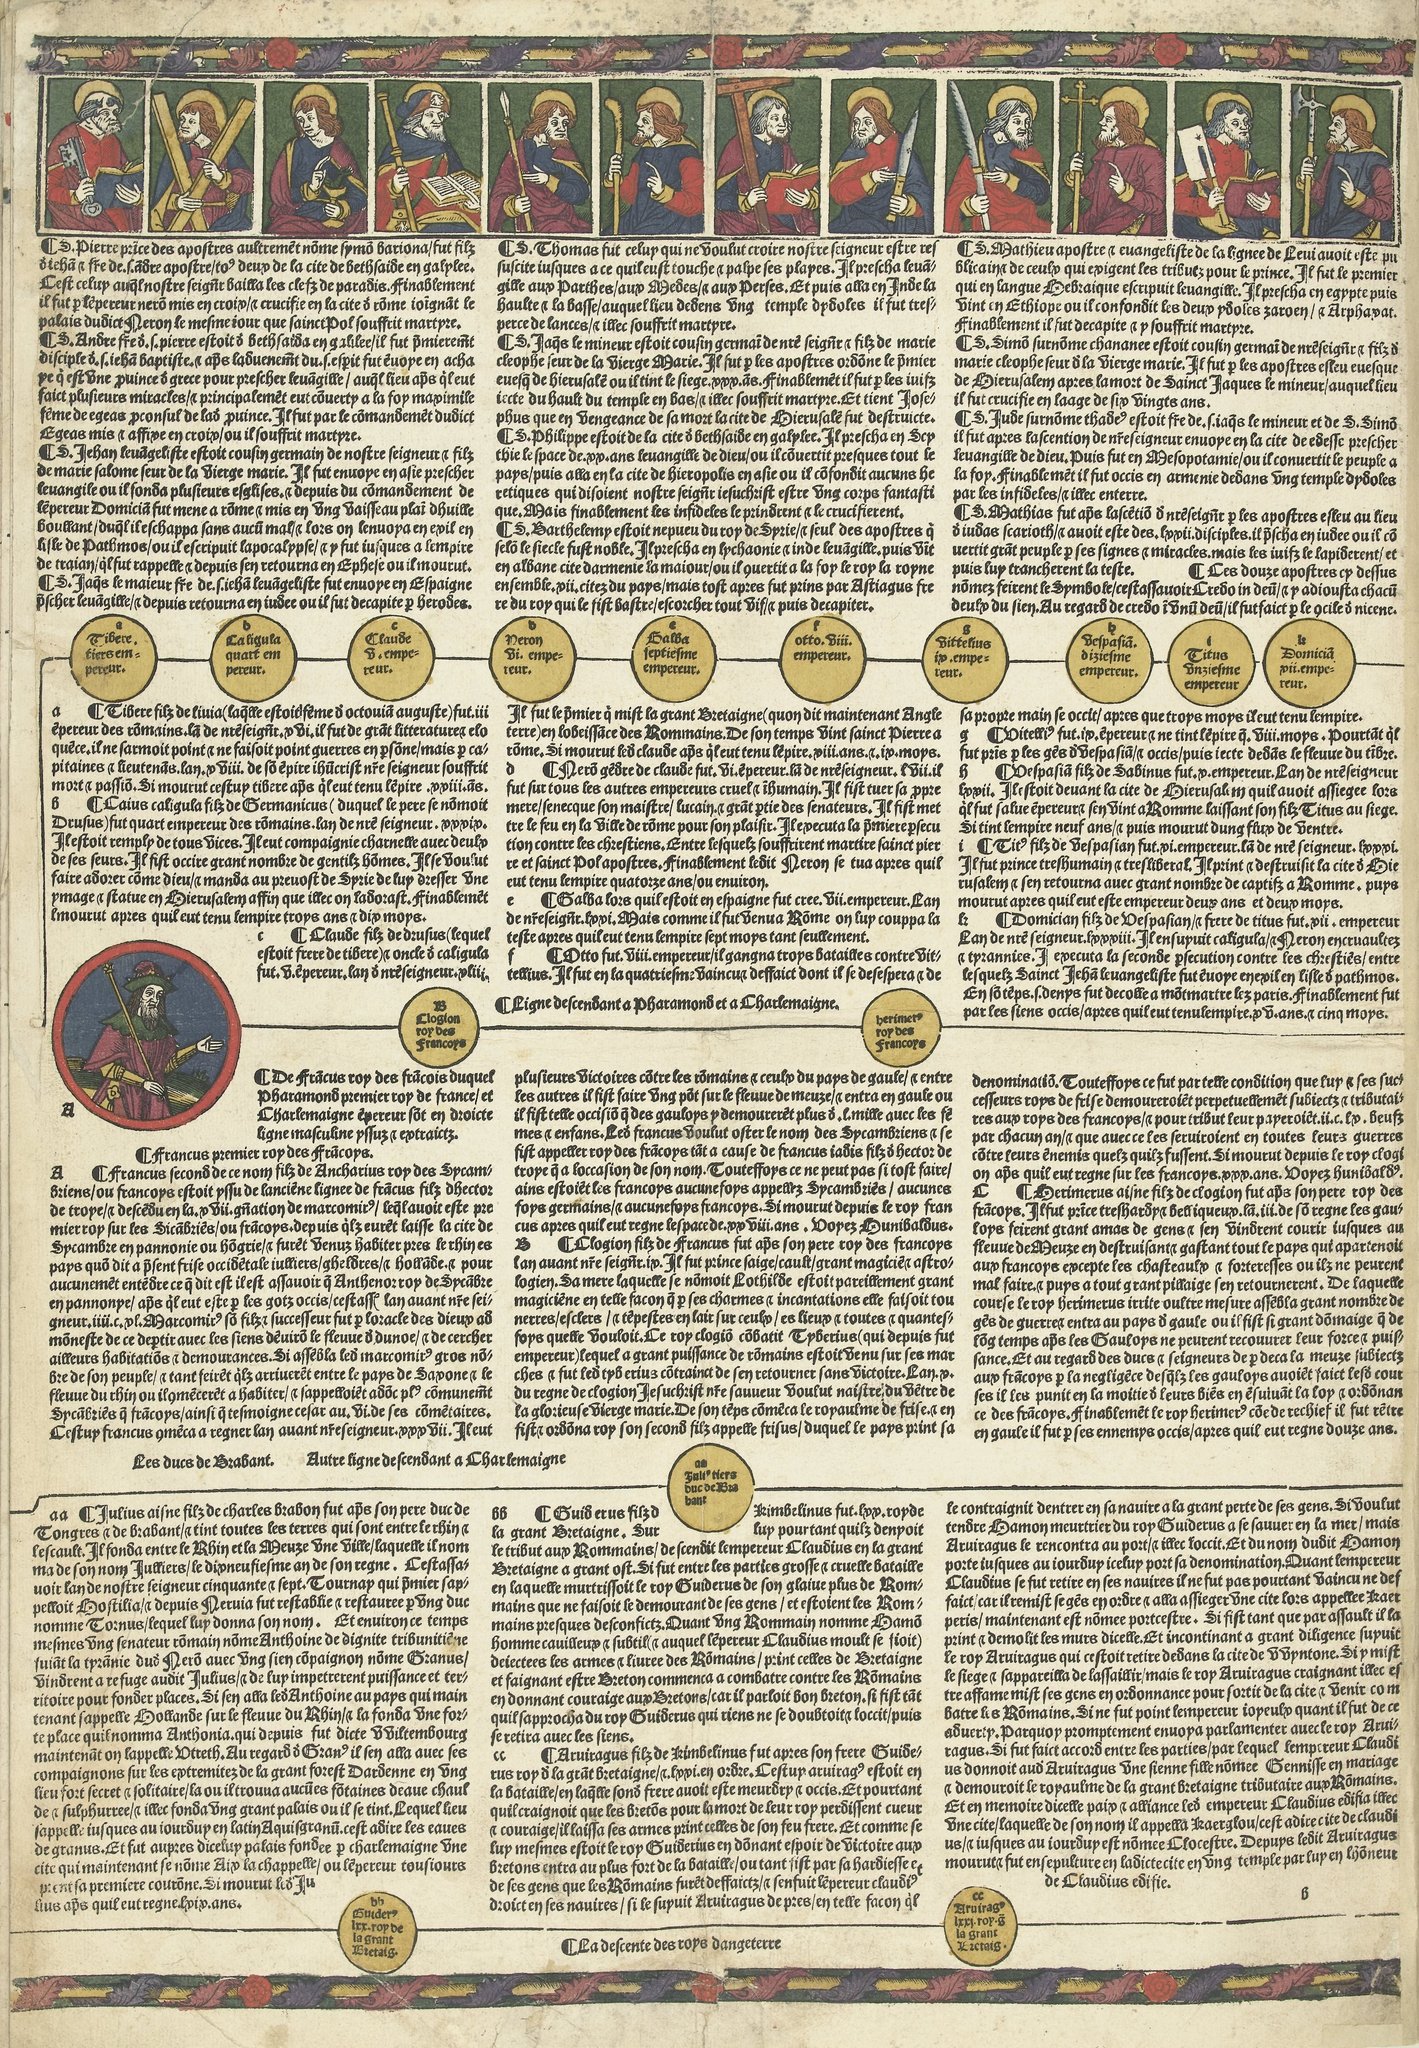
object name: print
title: Cronica Cronicarum (...), blad 9 verso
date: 1521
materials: paper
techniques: hand coloring, letterpress printing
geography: paris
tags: saints, the twelve apostles (as a group), usually with books or scrolls (not in biblical context) - ii - the apostles with matthias instead of judas iscariot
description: Blad 9 verso van een wereldkroniek. Tekst in boekdruk in het Frans in drie kolommen. Langs de bovenrand twaalf voorstellingen van de twaalf apostelen. Links midden een ronde voorstelling van Pharamond, de eerste koning van de Franken. De ronde voorstelling is verbonden met andere cirkels die gevuld zijn met namen. Deze vormen een schematische weergave van geslachtsregisters en vorstenopvolging, die zich uitstrekt over meerdere bladzijden van de kroniek. Geheel links een ornamentrand met profeten.